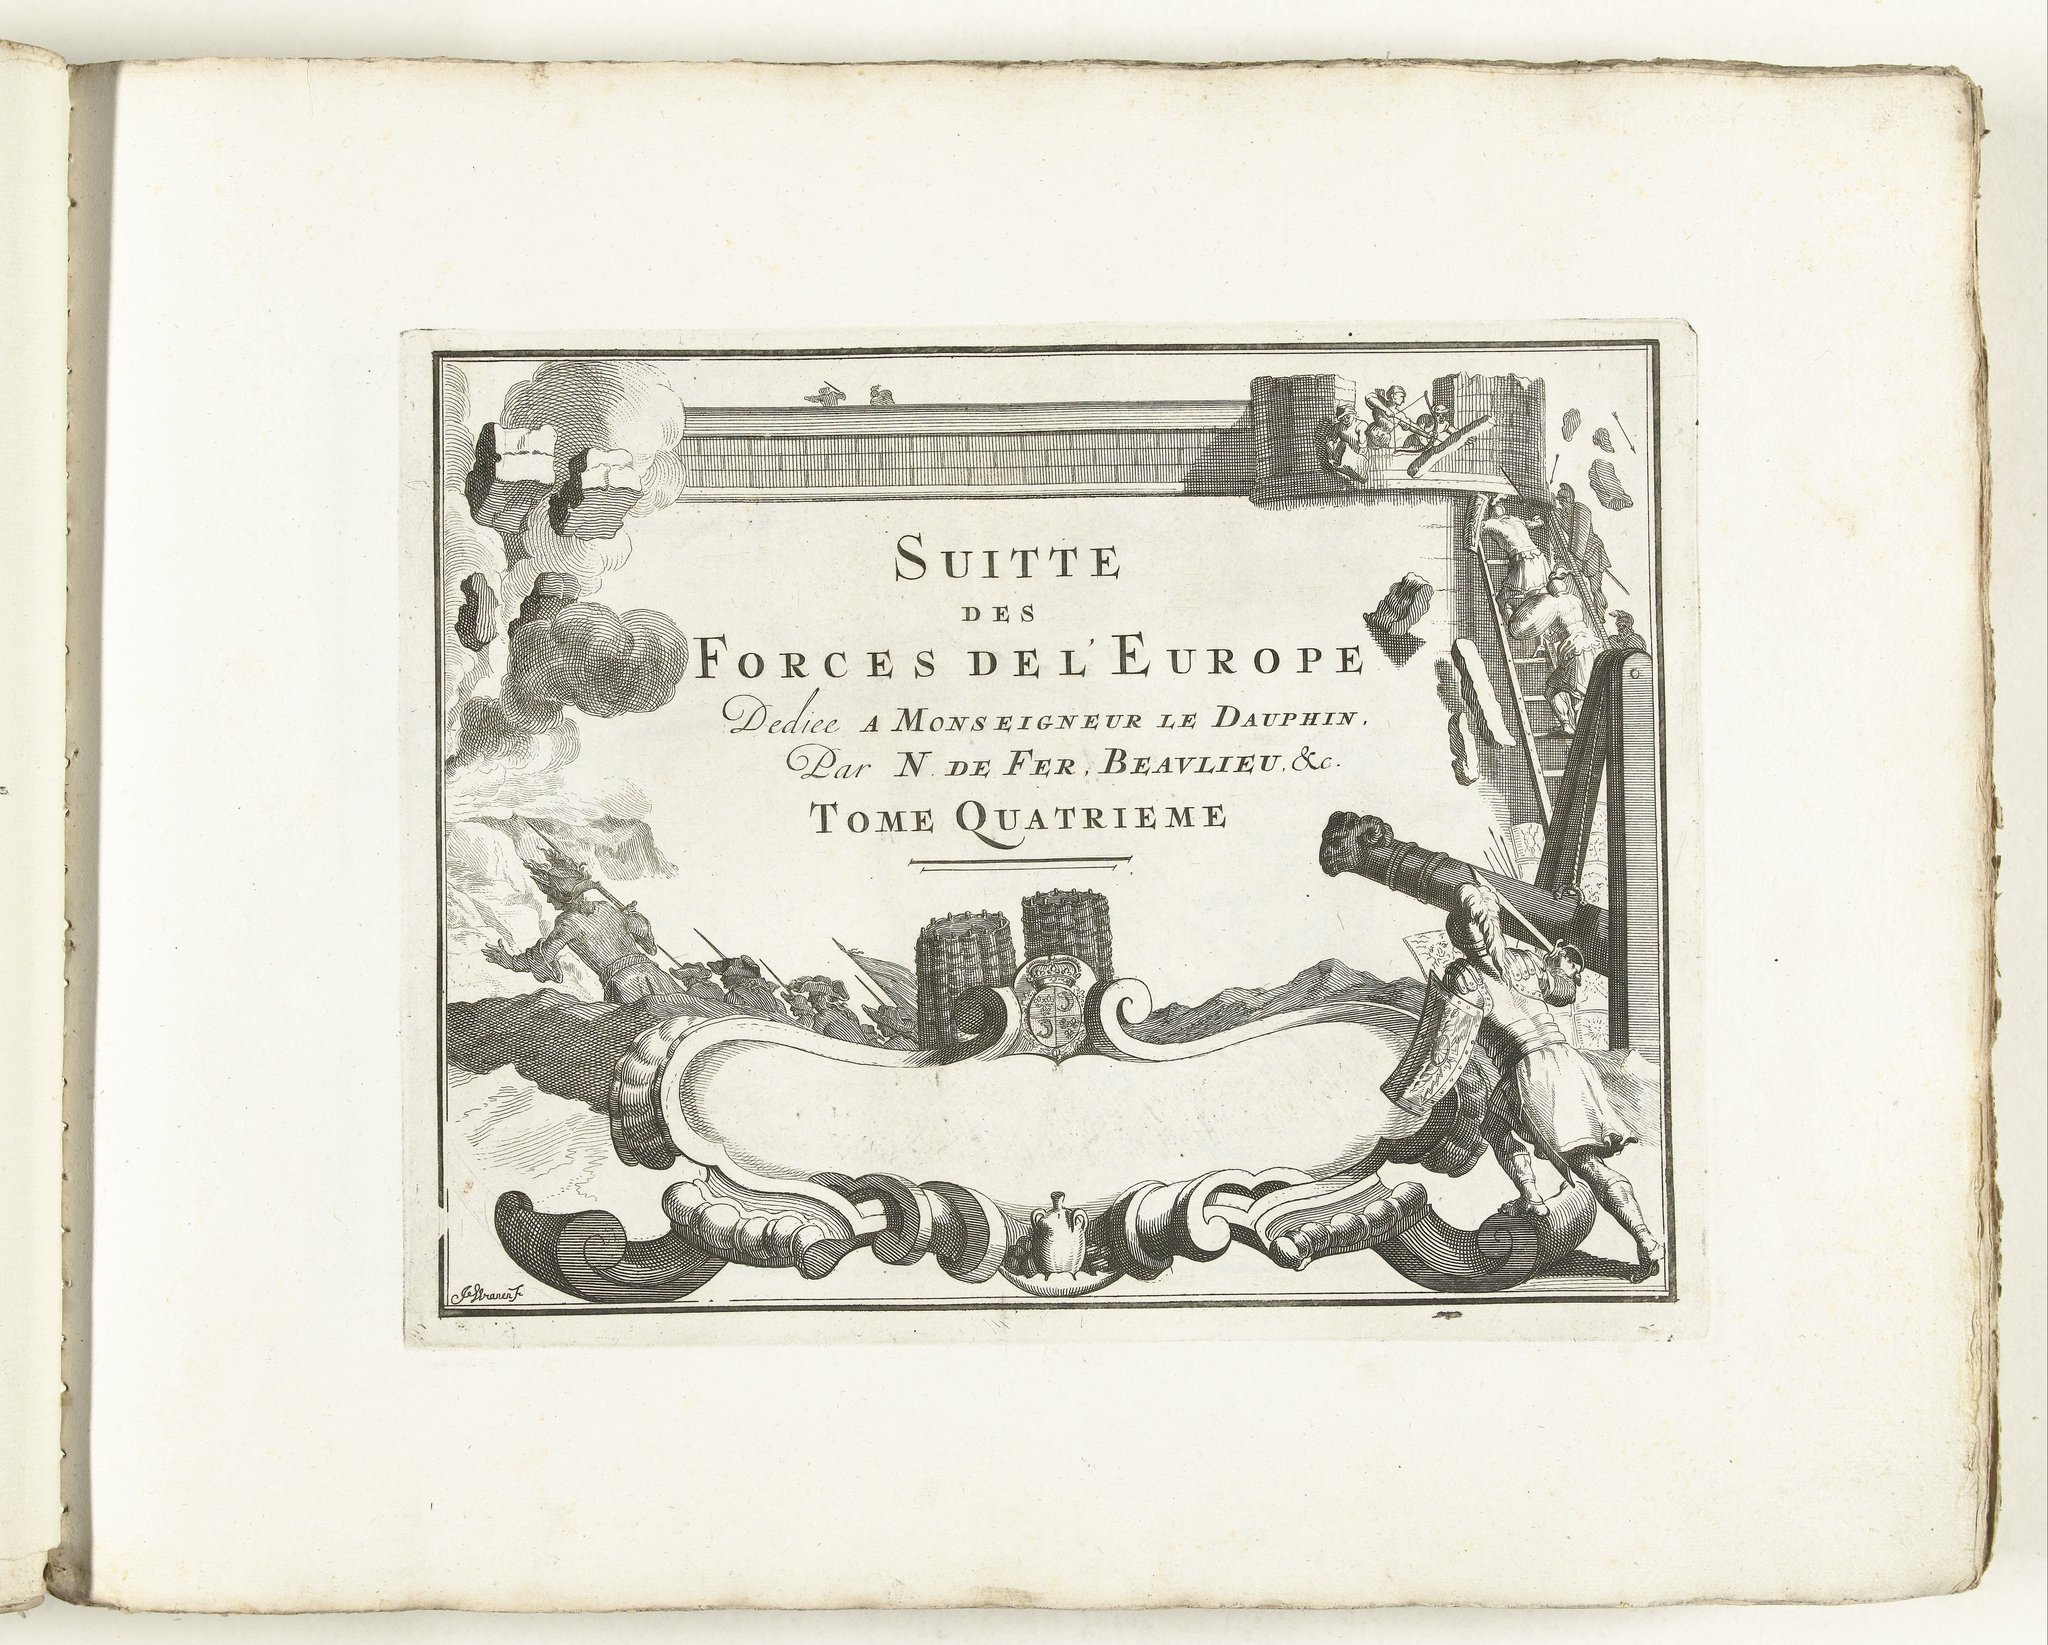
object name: print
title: Suitte des Forces de l'Europe / Tome Quatrieme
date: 1702-1703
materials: paper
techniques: etching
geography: amsterdam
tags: siege, position war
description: Titelprent met de bestorming van een vestingmuur. Titelprent voor het vierde deel van het prentwerk: Les Forces de l'Europe, Asie, Afrique et Amerique, uitgegeven ca. 1702. Ongenummerd [71]. Het prentwerk bestaat in totaal uit 276 genummerde platen van vermaarde sterke steden en vestingen in het kader van de Spaanse Successieoorlog. Voor het merendeel zijn deze platen gekopieerd naar de anonieme Franse platen: in Les forces de l'Europe en in: Le theatre de la guerre, dans les Pays-Bas, beide oorspronkelijk uitgegeven door Nicolas de Fer te Parijs (1693-1697) in het kader van de Negenjarige Oorlog. Titel in het Frans.